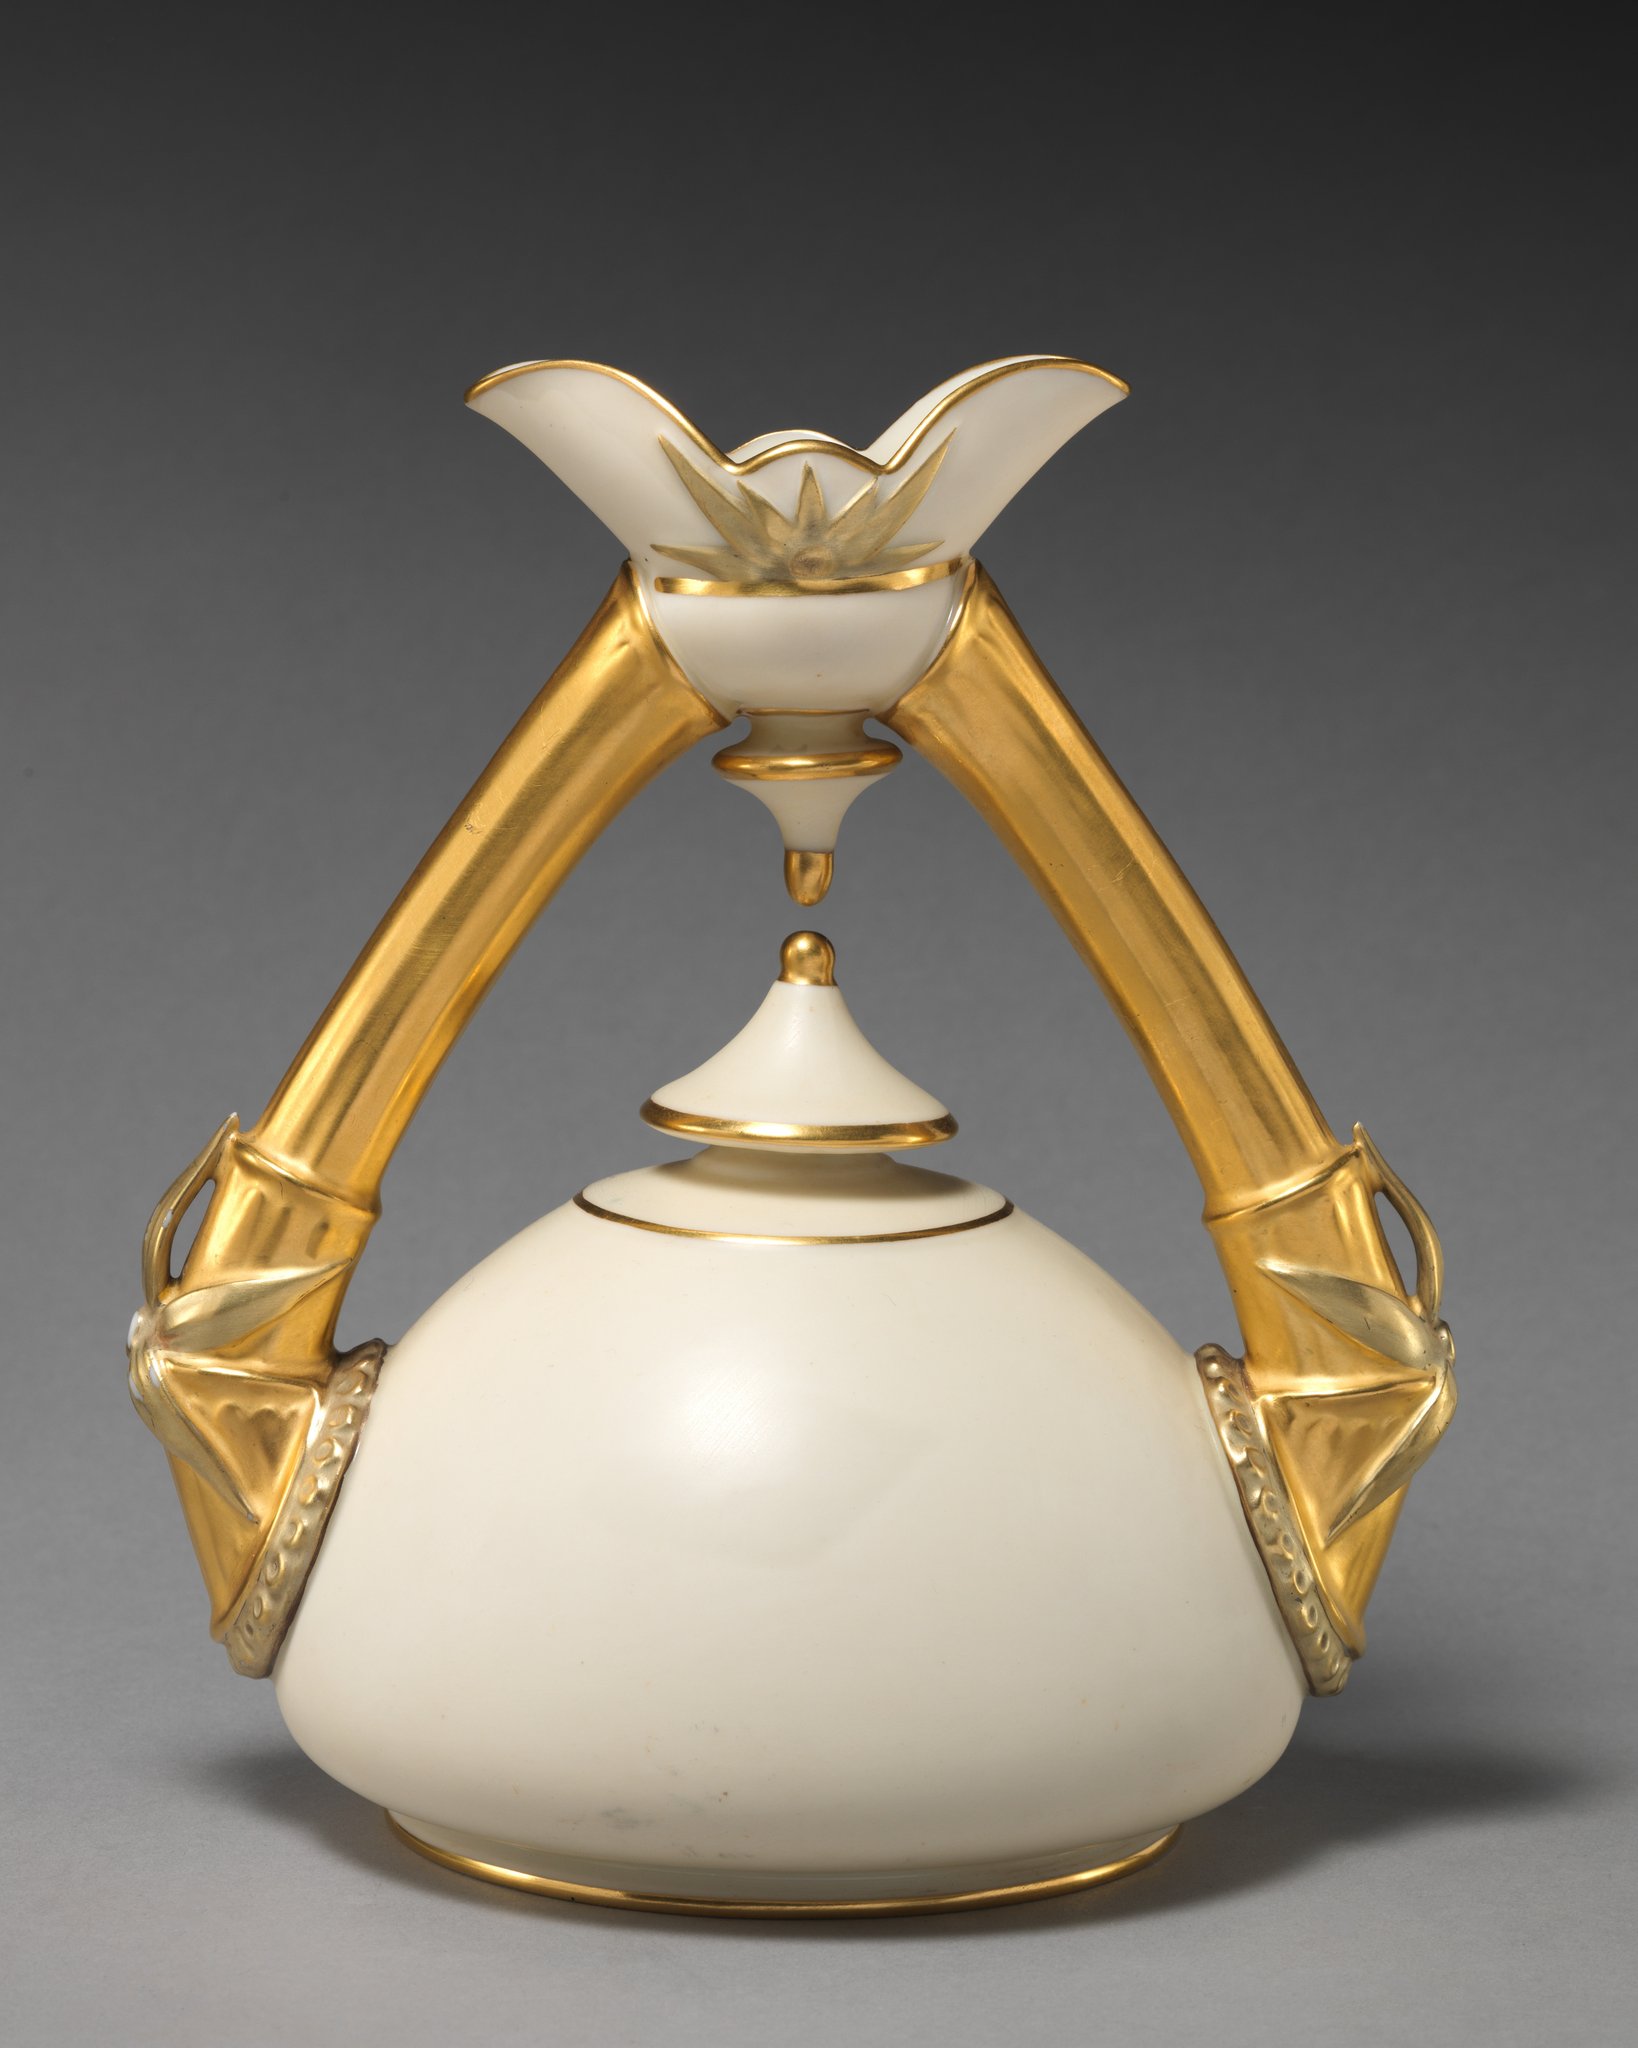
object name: vase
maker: worcester factory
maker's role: maker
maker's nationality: british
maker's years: 1751-2008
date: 1886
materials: bone china